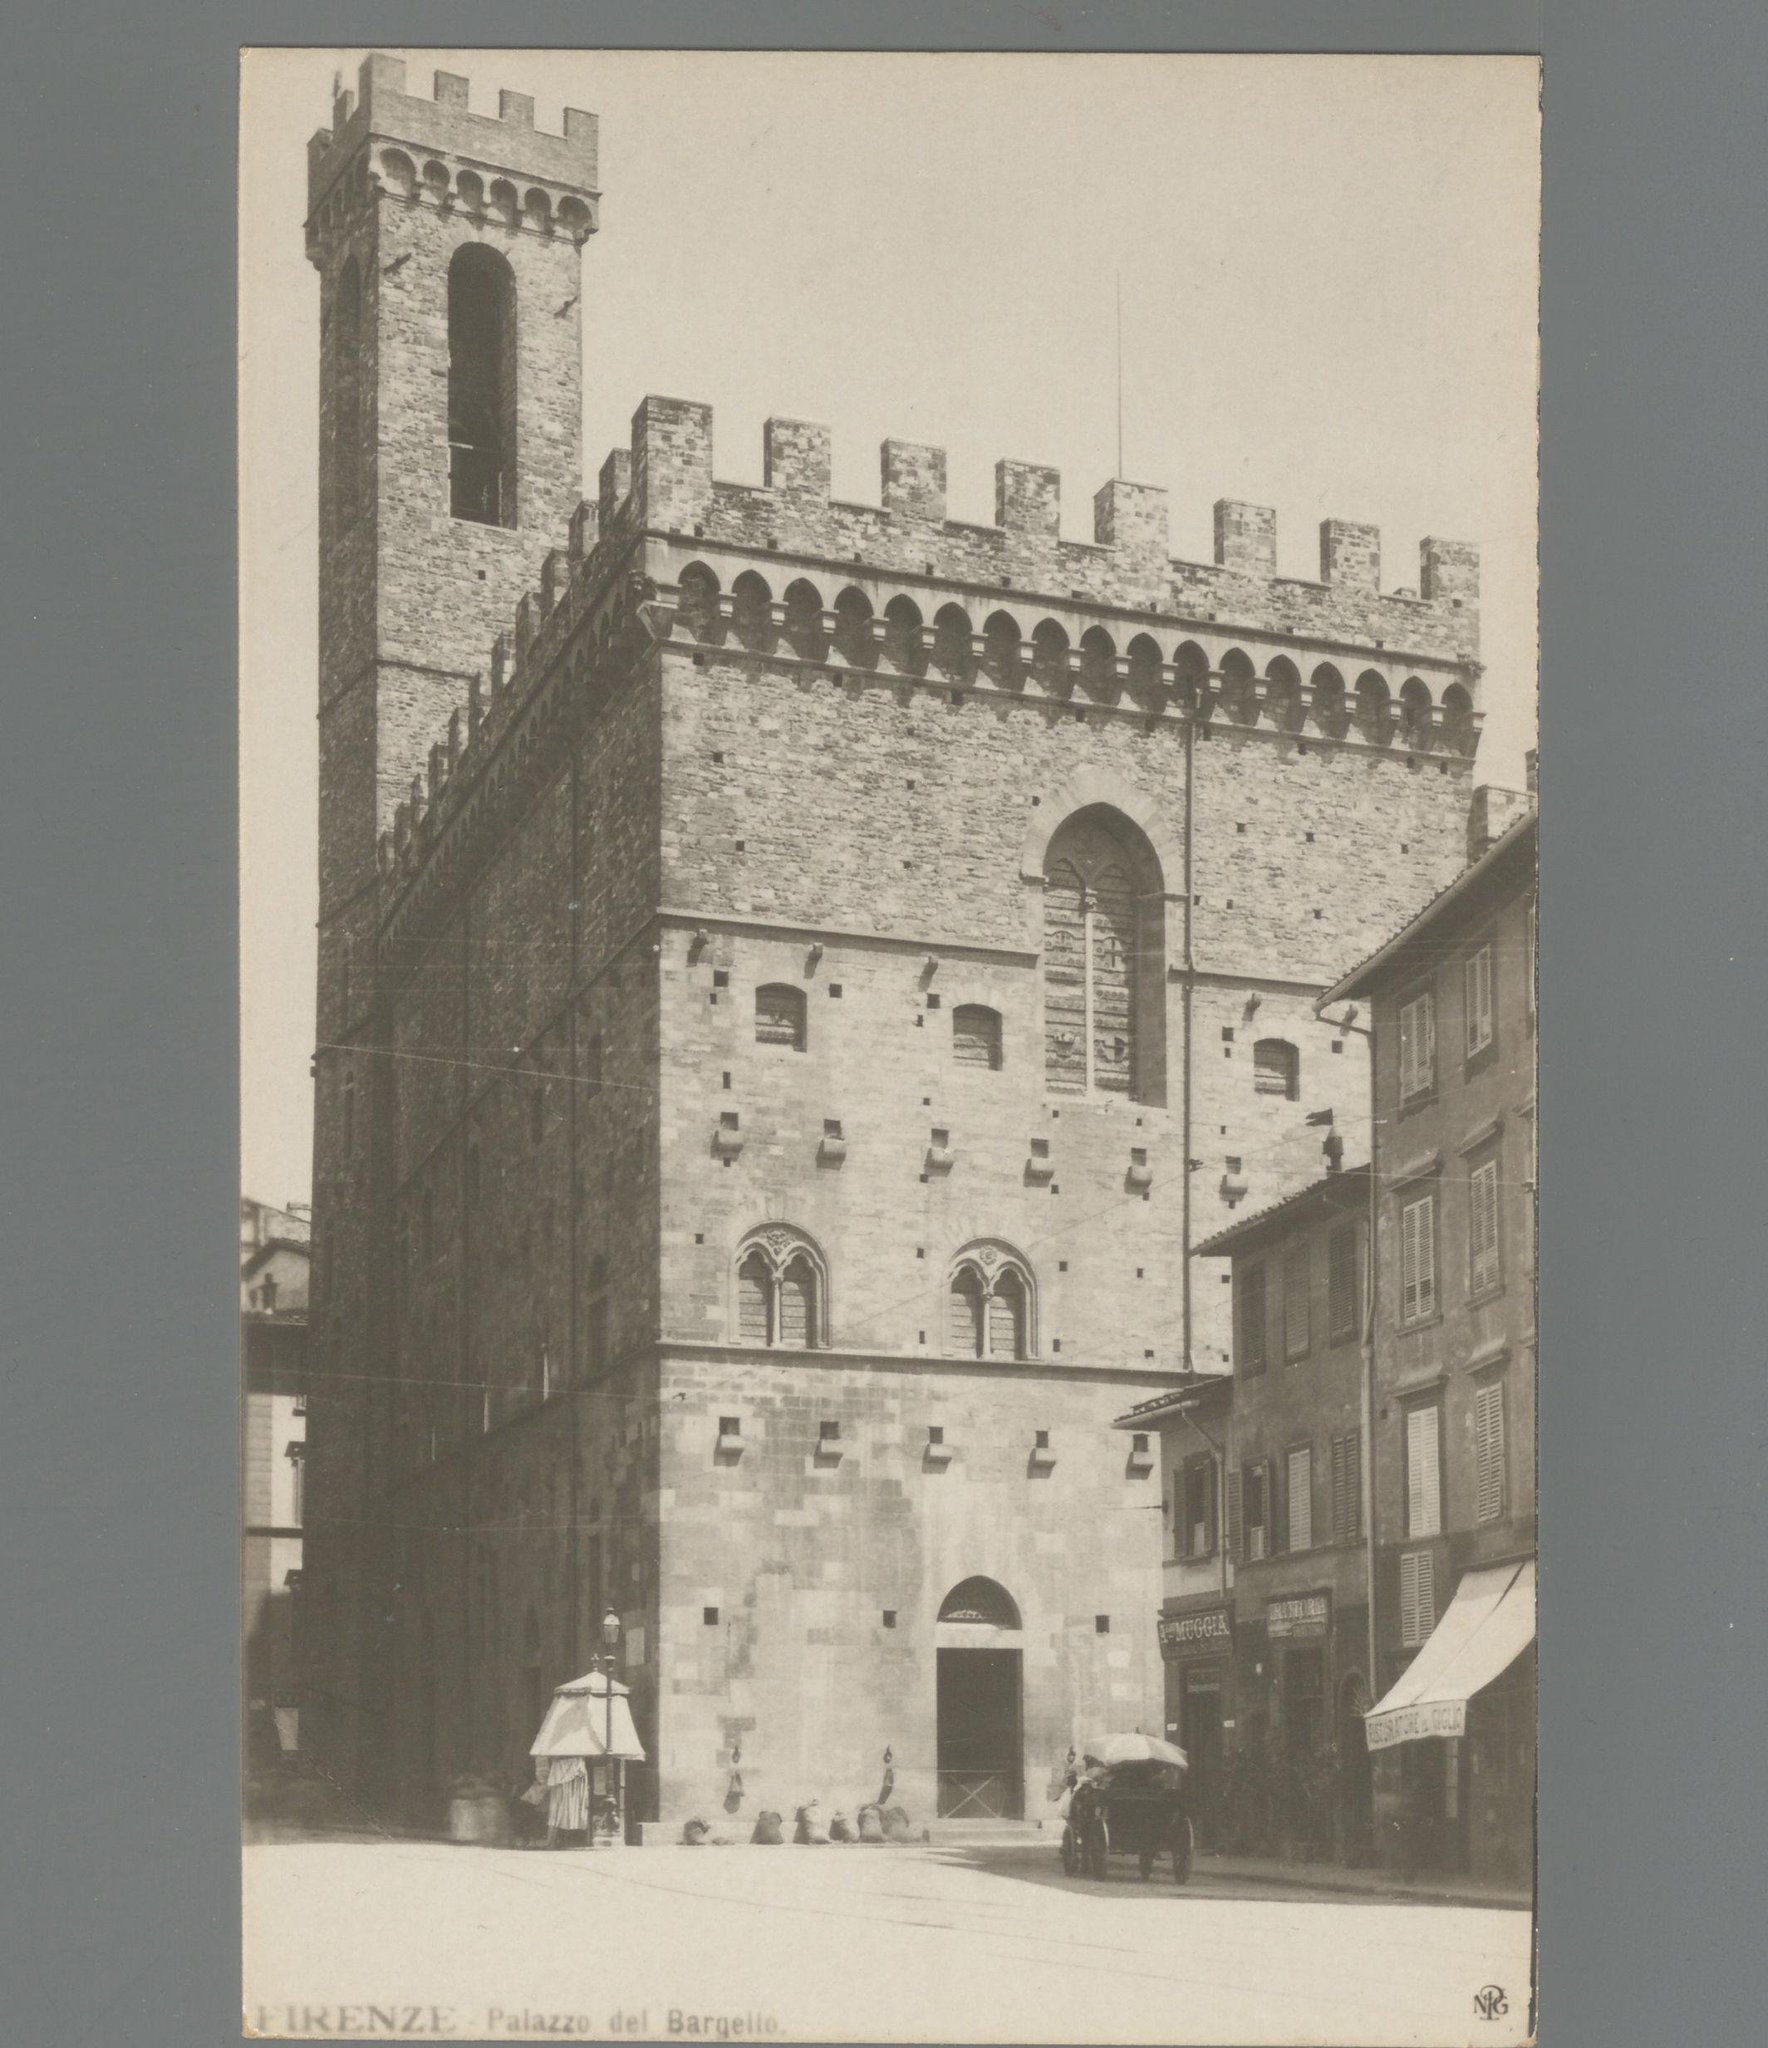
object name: ansichtkaart, prentbriefkaart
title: Firenze. Palazzo del Bargello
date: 1900-1906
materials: paper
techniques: gelatin silver print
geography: italy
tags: palace, permanent exhibition, museum, city-view, and landscape with man-made constructions (+ city(-scape) with figures, staffage)